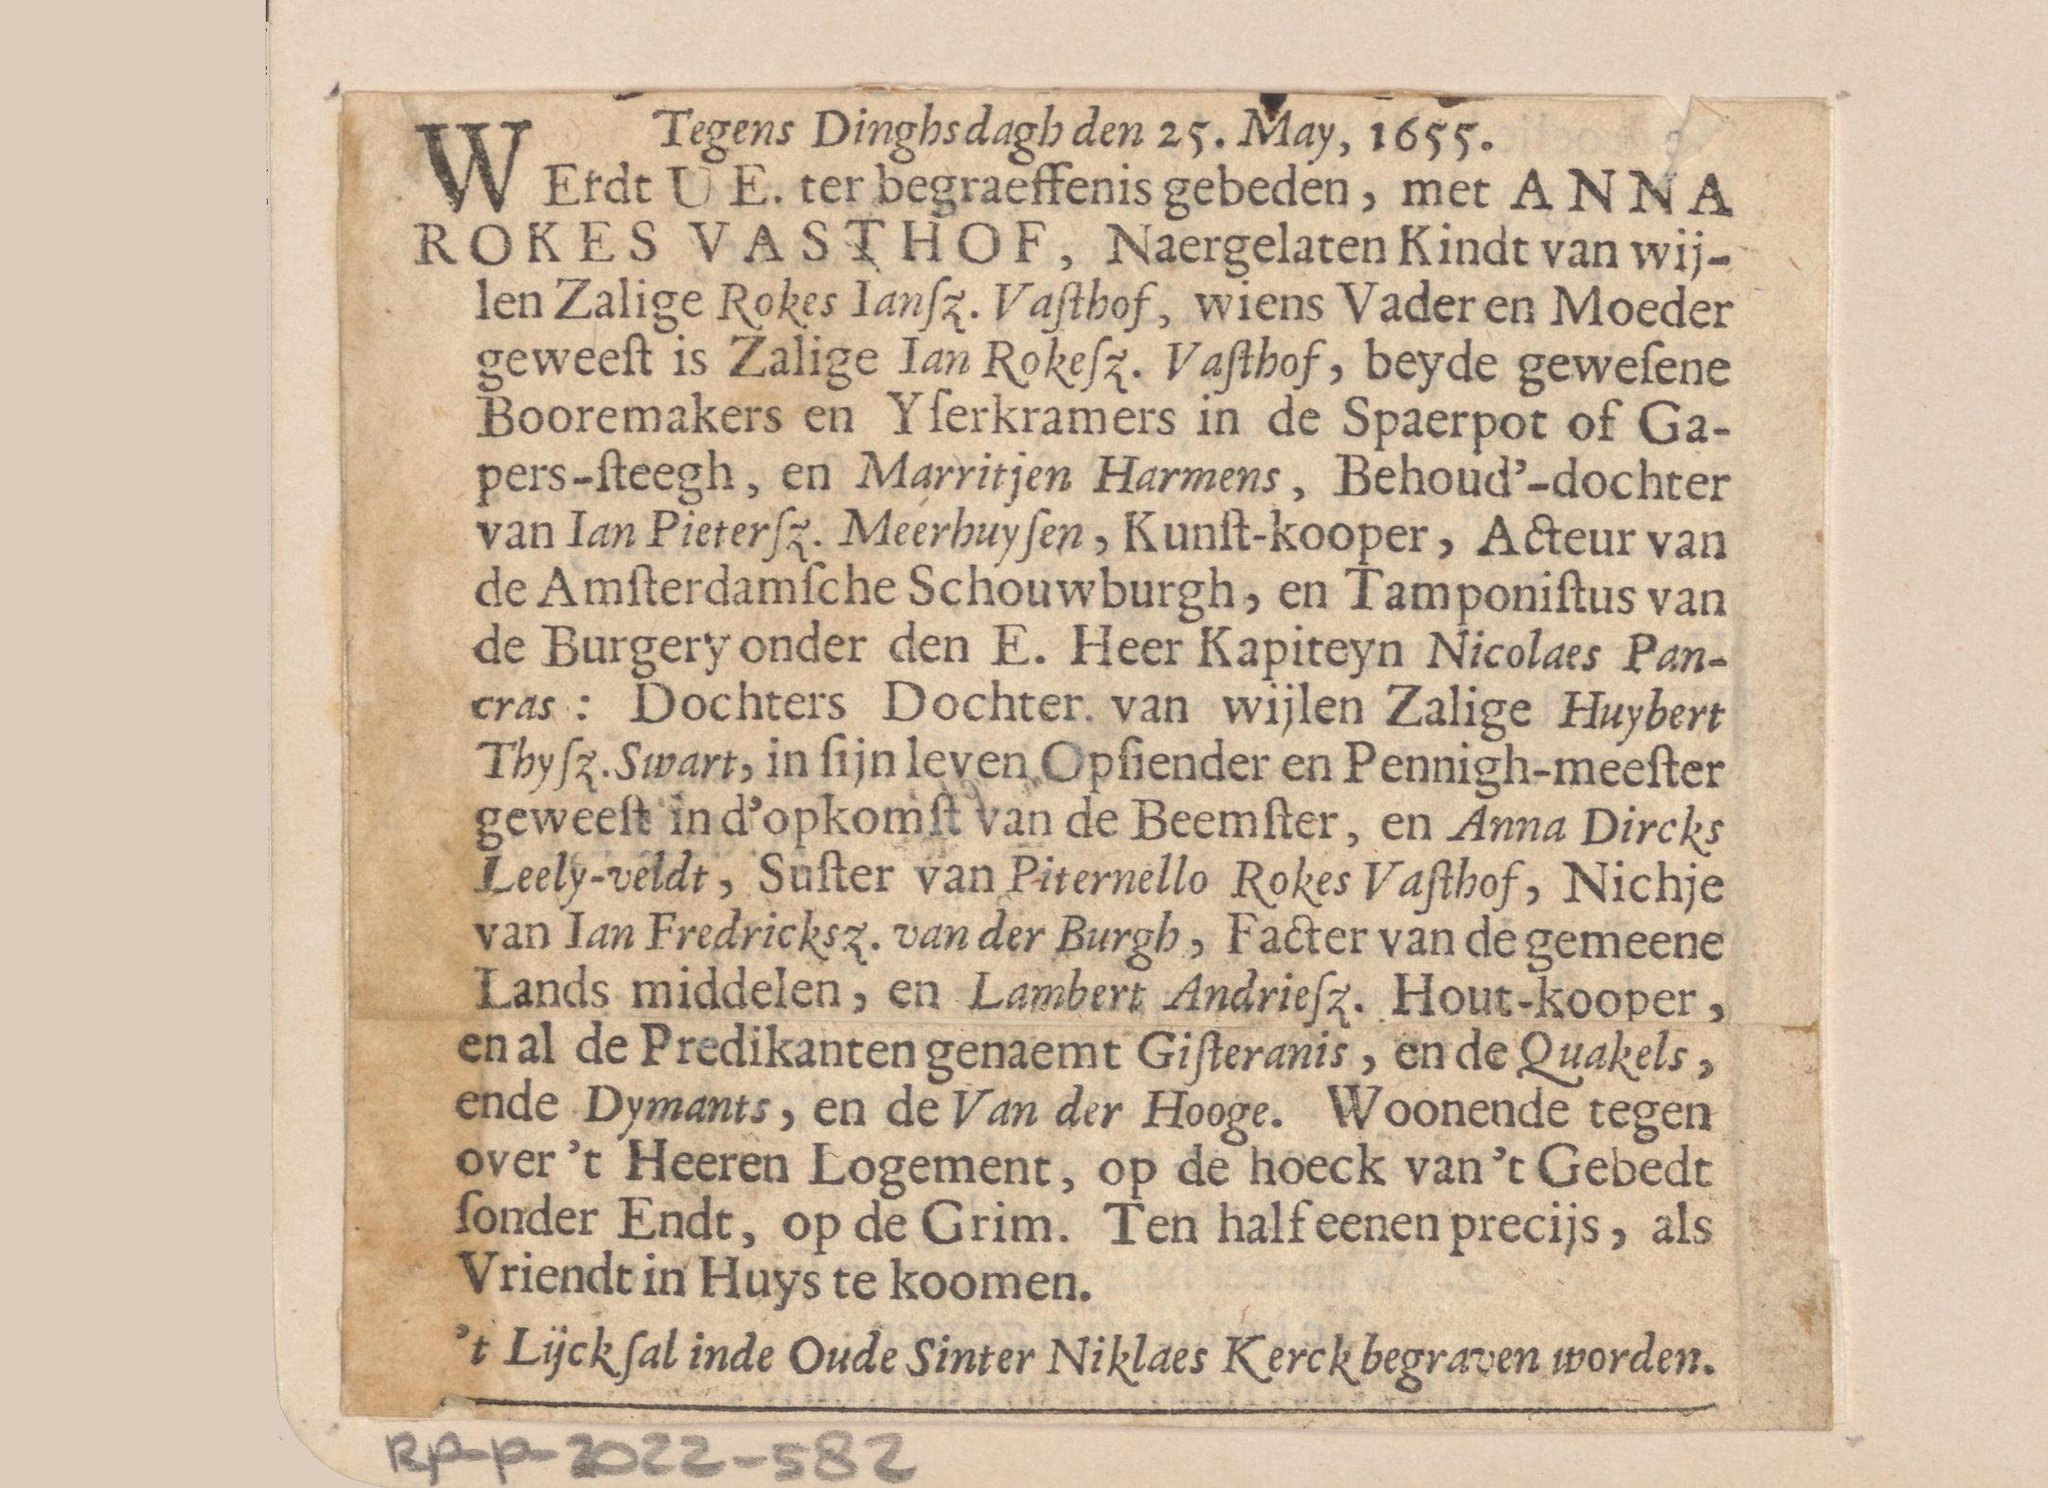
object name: clipping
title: Bericht over het overlijden van Anna Rokes Vasthof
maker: jan claesz ten hoorn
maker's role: publisher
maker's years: 1638-1715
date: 1677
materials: paper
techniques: letterpress printing, snipping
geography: amsterdam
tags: jan pietersz. meerhuysen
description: Prent waarschijnlijk uit: Den Vermakelycken Opdisser, (...). Amsterdam: Jan Claesz. ten Hoorn, 1677.